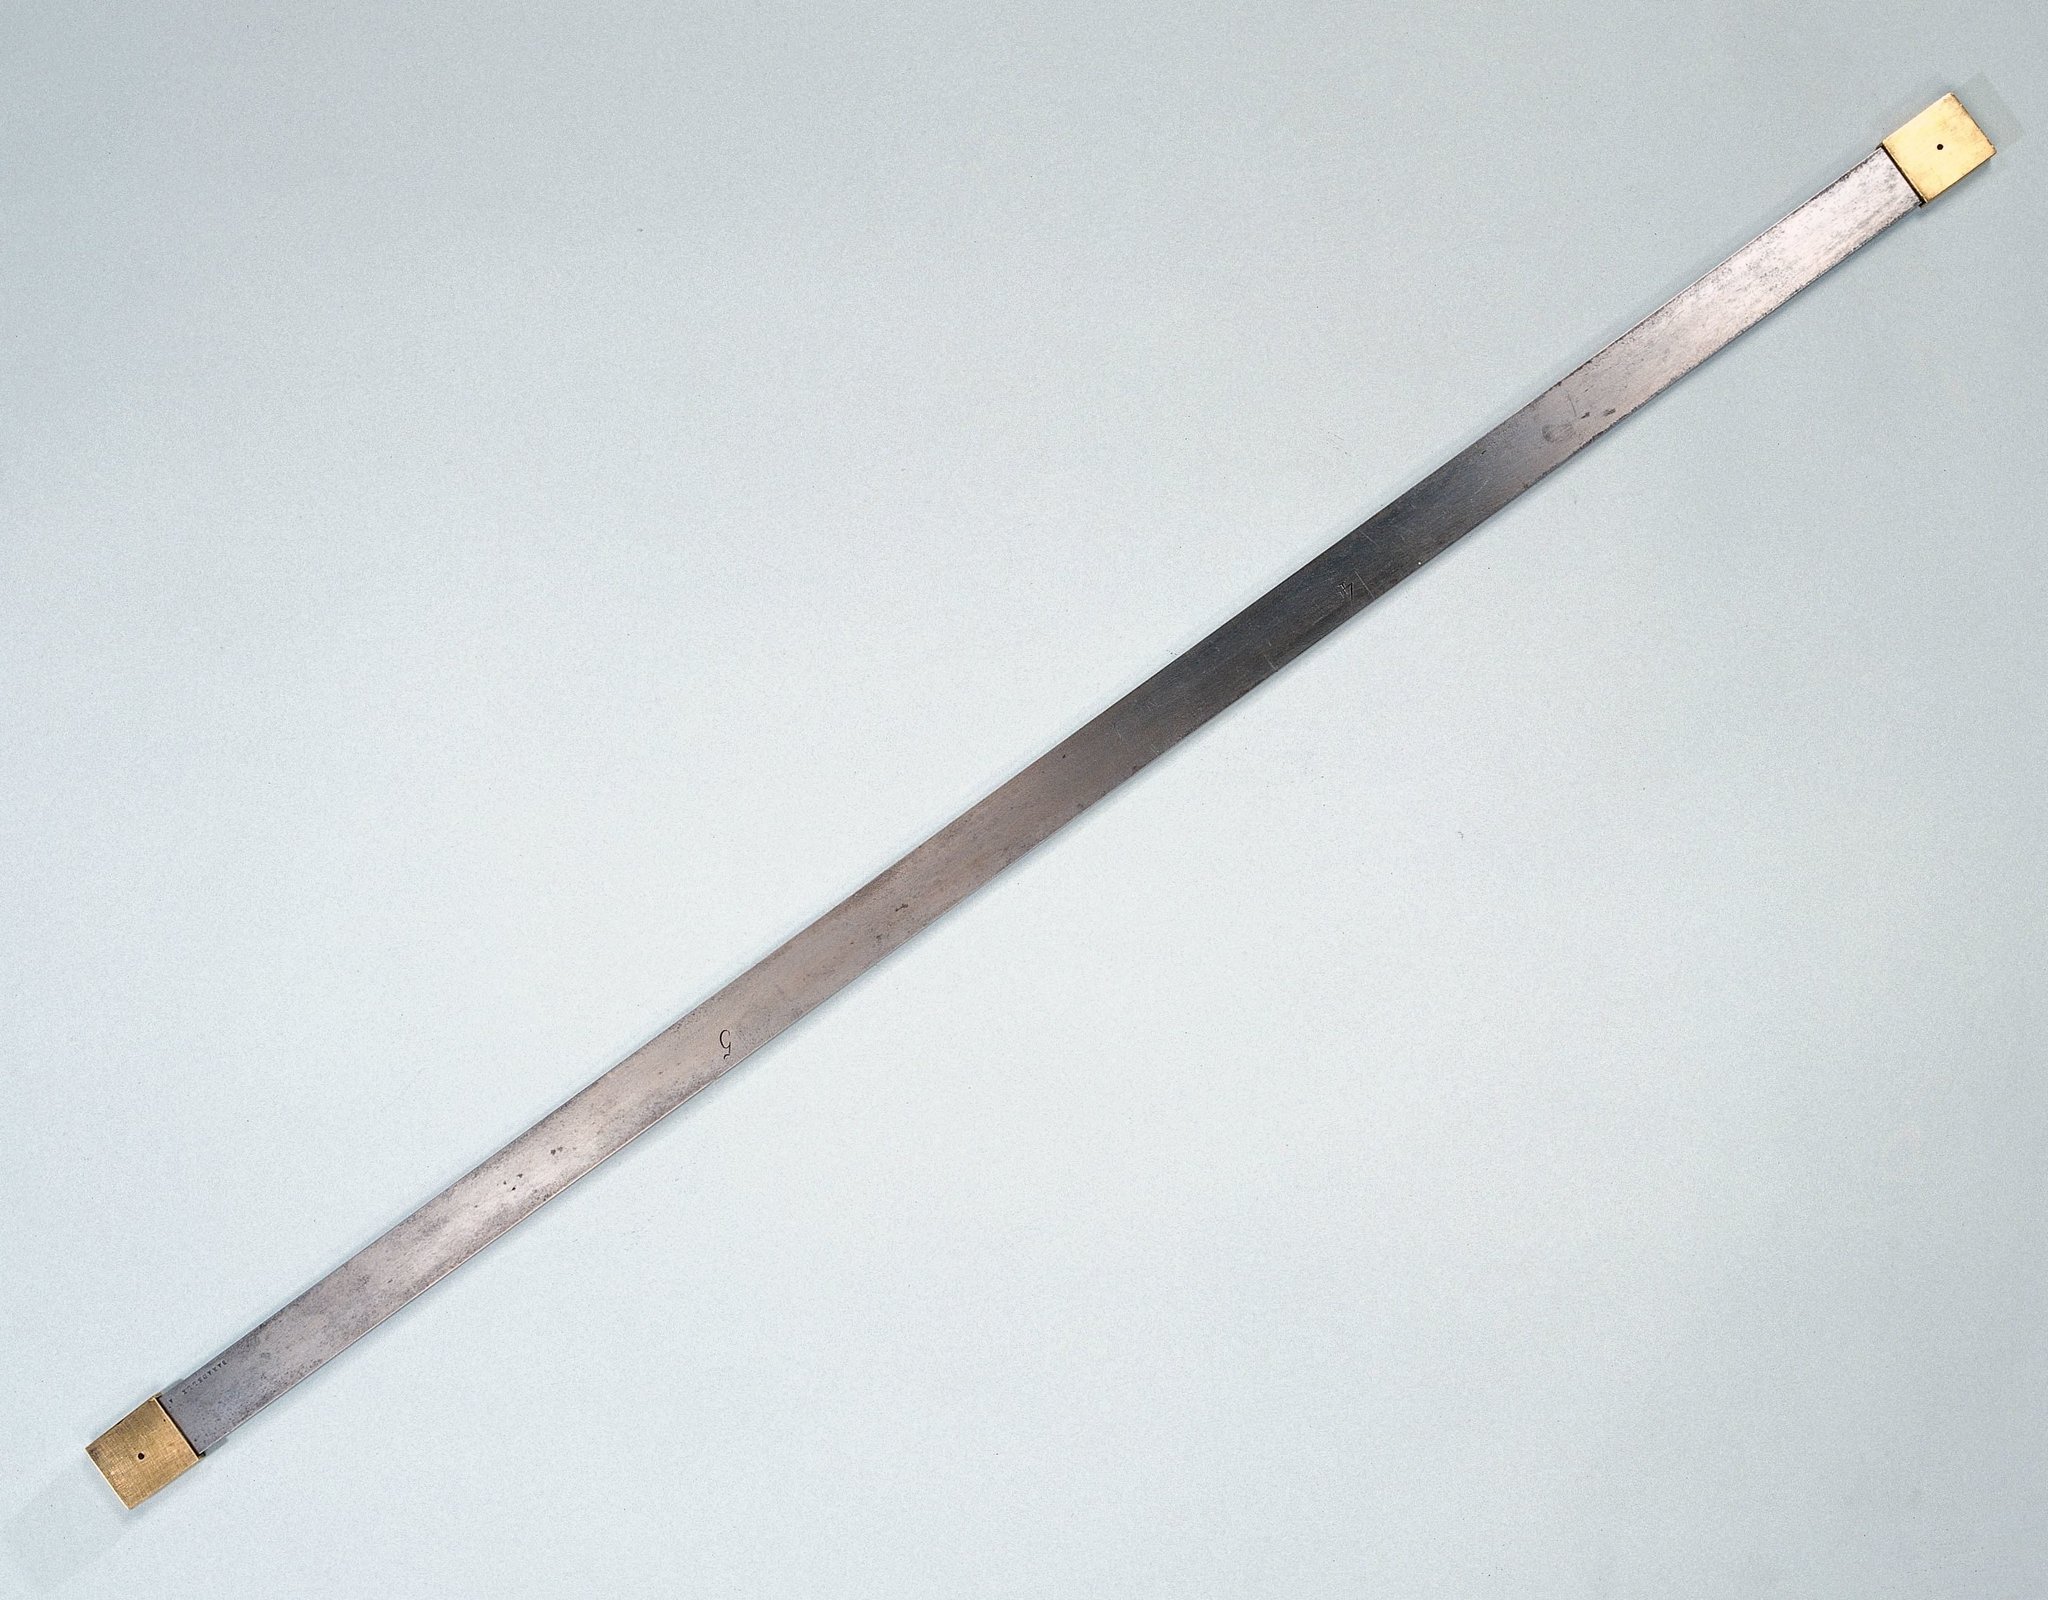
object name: measuring rod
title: Deux mètres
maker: jacques baradelle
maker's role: instrument maker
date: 1800-1825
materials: copper, iron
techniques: forging, striking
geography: paris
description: Ruler measuring 1 metre. Brass and copper, c. 1800. Dutch professors J.H. van Swinden (1746-1823) and H. Aeneae (1743-1810) served as delegates from the Batavian Republic on the French commission that established the new system of weights and measures in 1798 and 1799: the metric system. The Dutchmen brought examples of the new units of weight and measure back from France. This may have been one of those rulers. On one side is an old French unit of measurement. The other marks the metric system in decimals. To avoid wear, the ends of the ruler were reinforced with brass endpieces, ensuring that the precise length of the ruler would remain accurate.